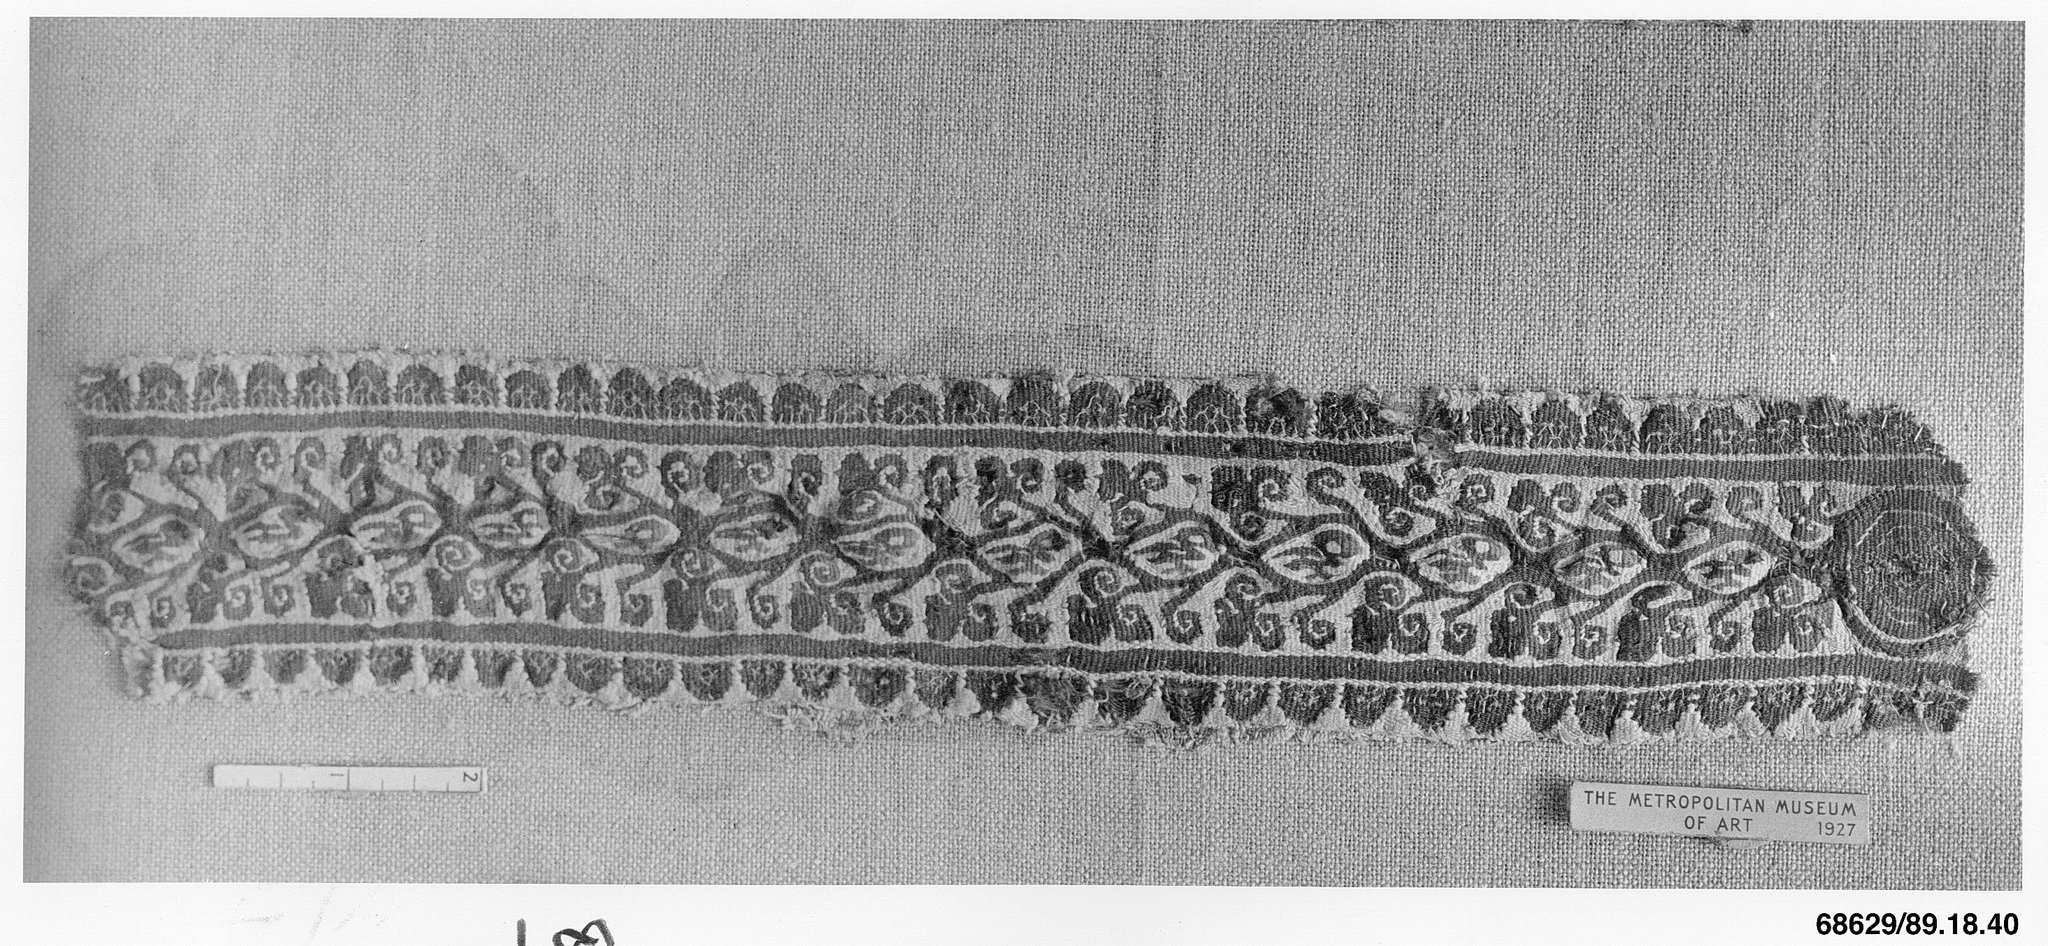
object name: textile fragment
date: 201-400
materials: linen, wool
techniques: weave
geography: egypt